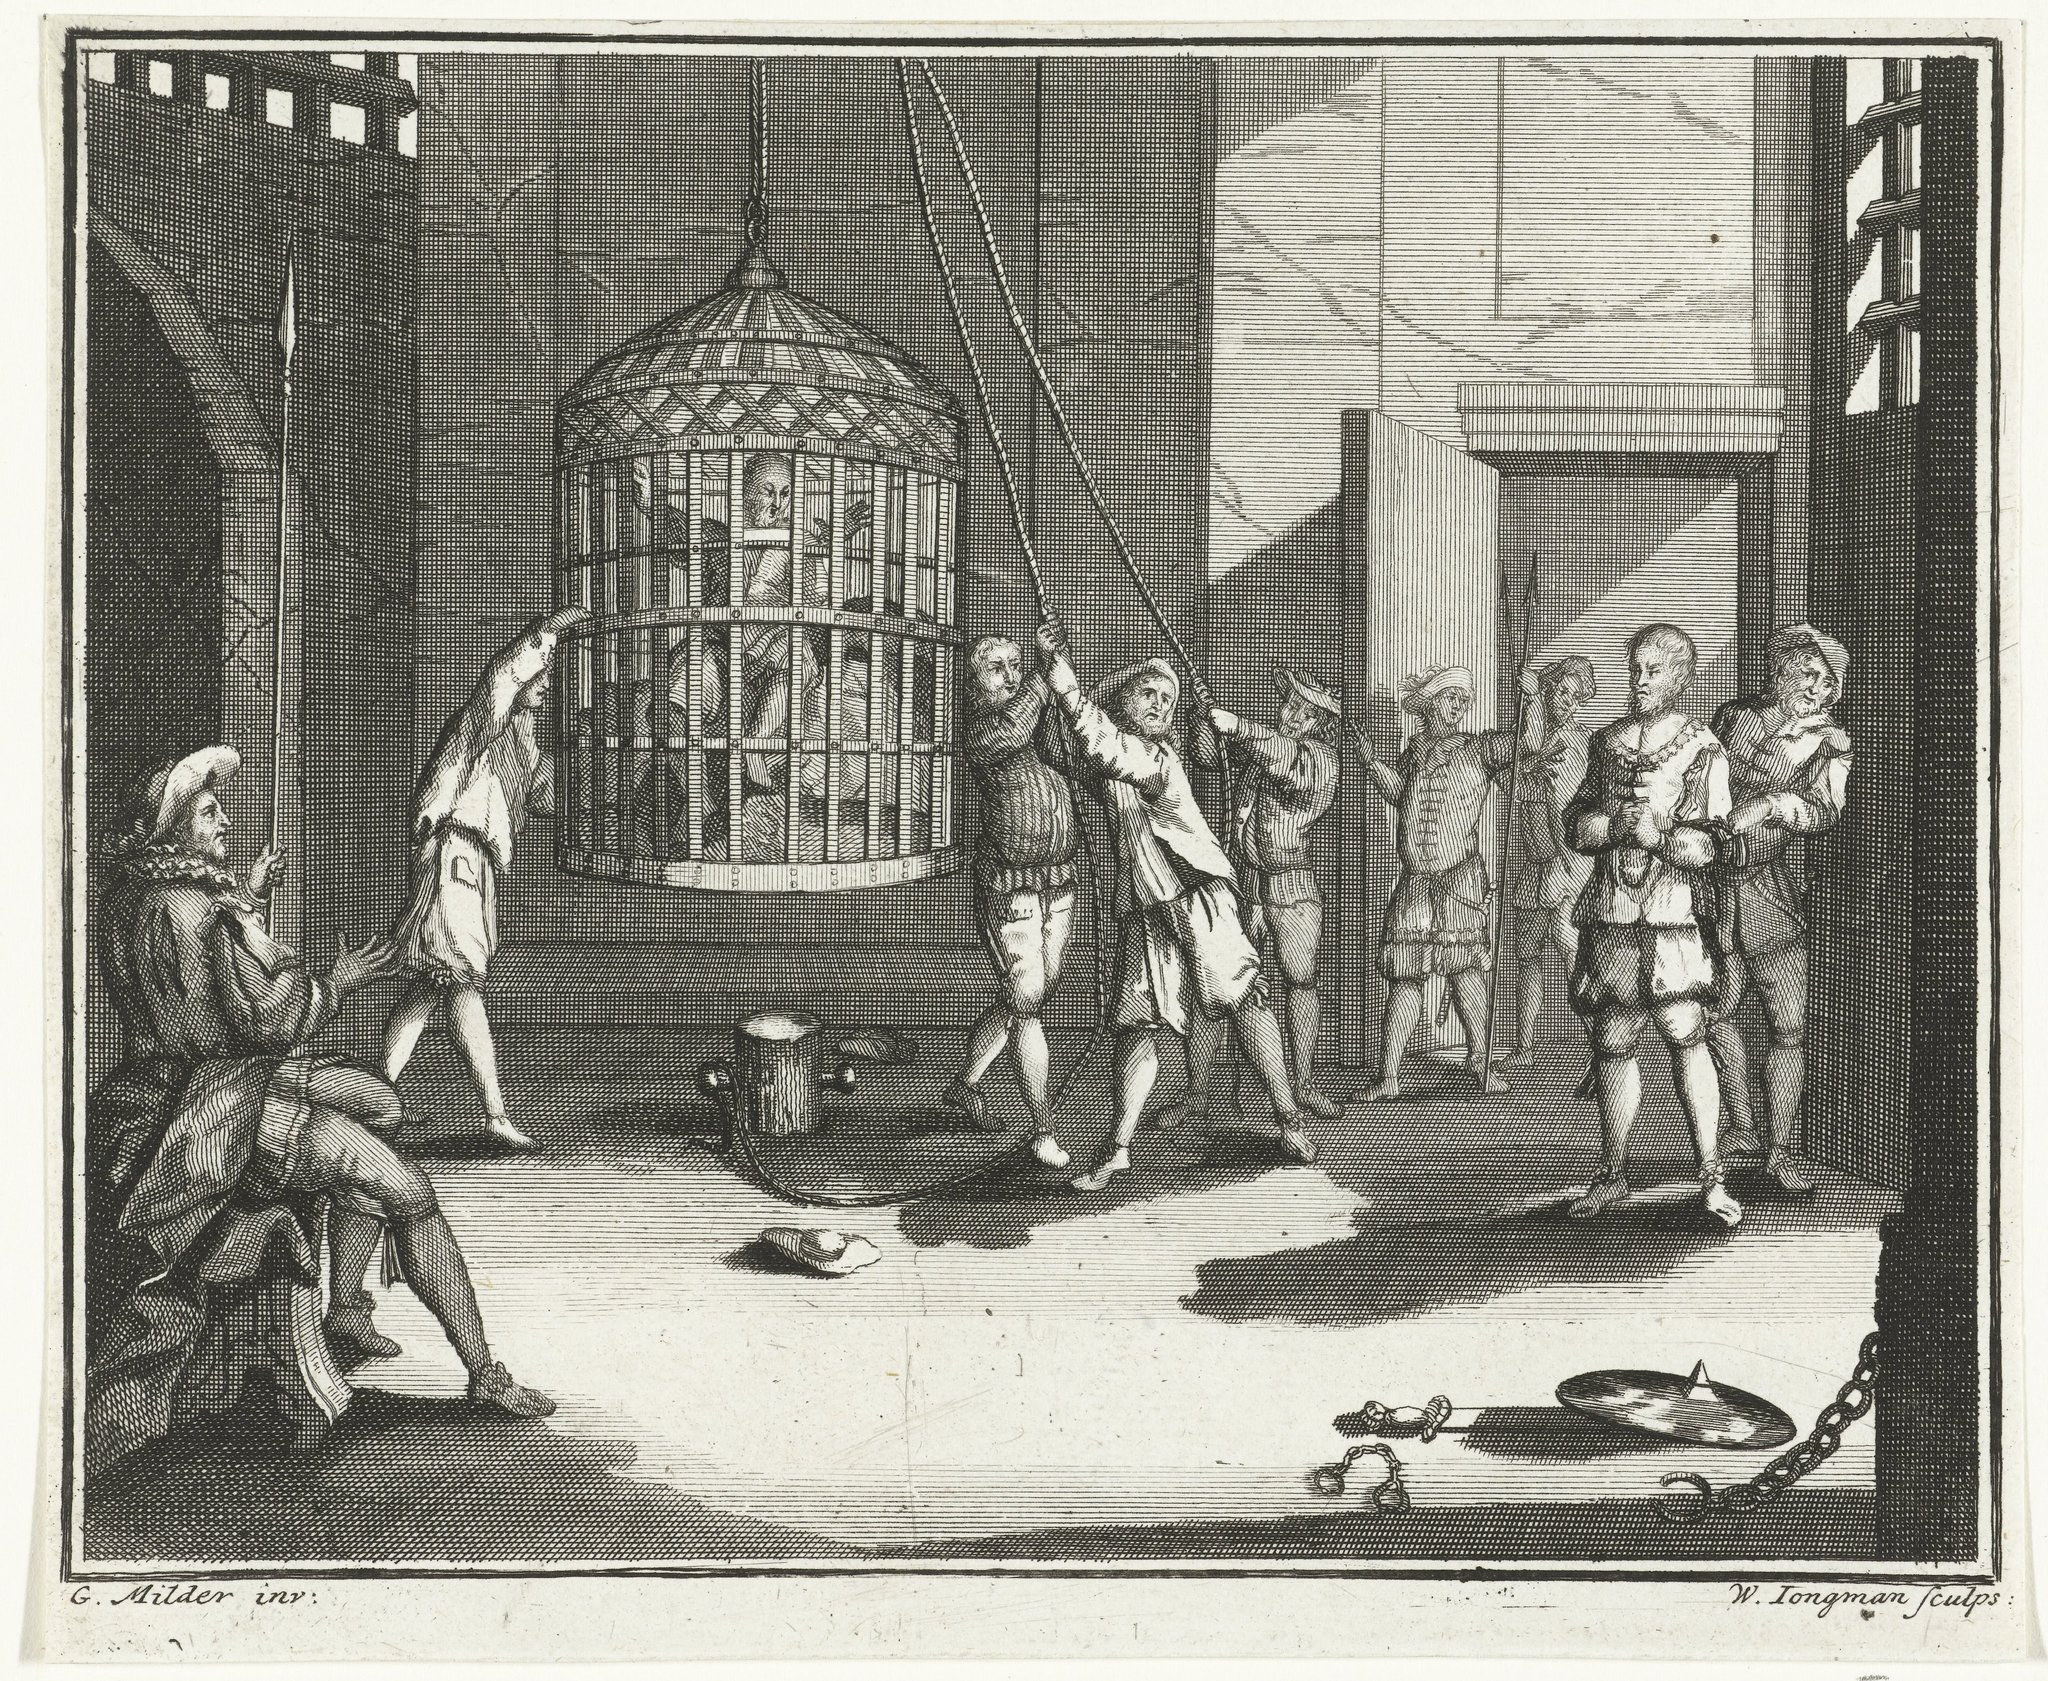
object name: print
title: Jan Kruyze en Willem van Deutichem om beurten gestraft in de Wassenaarskooi te Hattem, 1520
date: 1719-1728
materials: paper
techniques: etching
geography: northern netherlands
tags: public punishment (death not intended or involved)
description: Jan Kruyze, rentmeester van Salland en Willem van Deutichem, schout van Deventer worden als straf om beurten opgesloten in de Wassenaarskooi, de kooi van Jan van Wassenaar, te Hattem, 1520. Scène speelt zich af in de gevangenis.